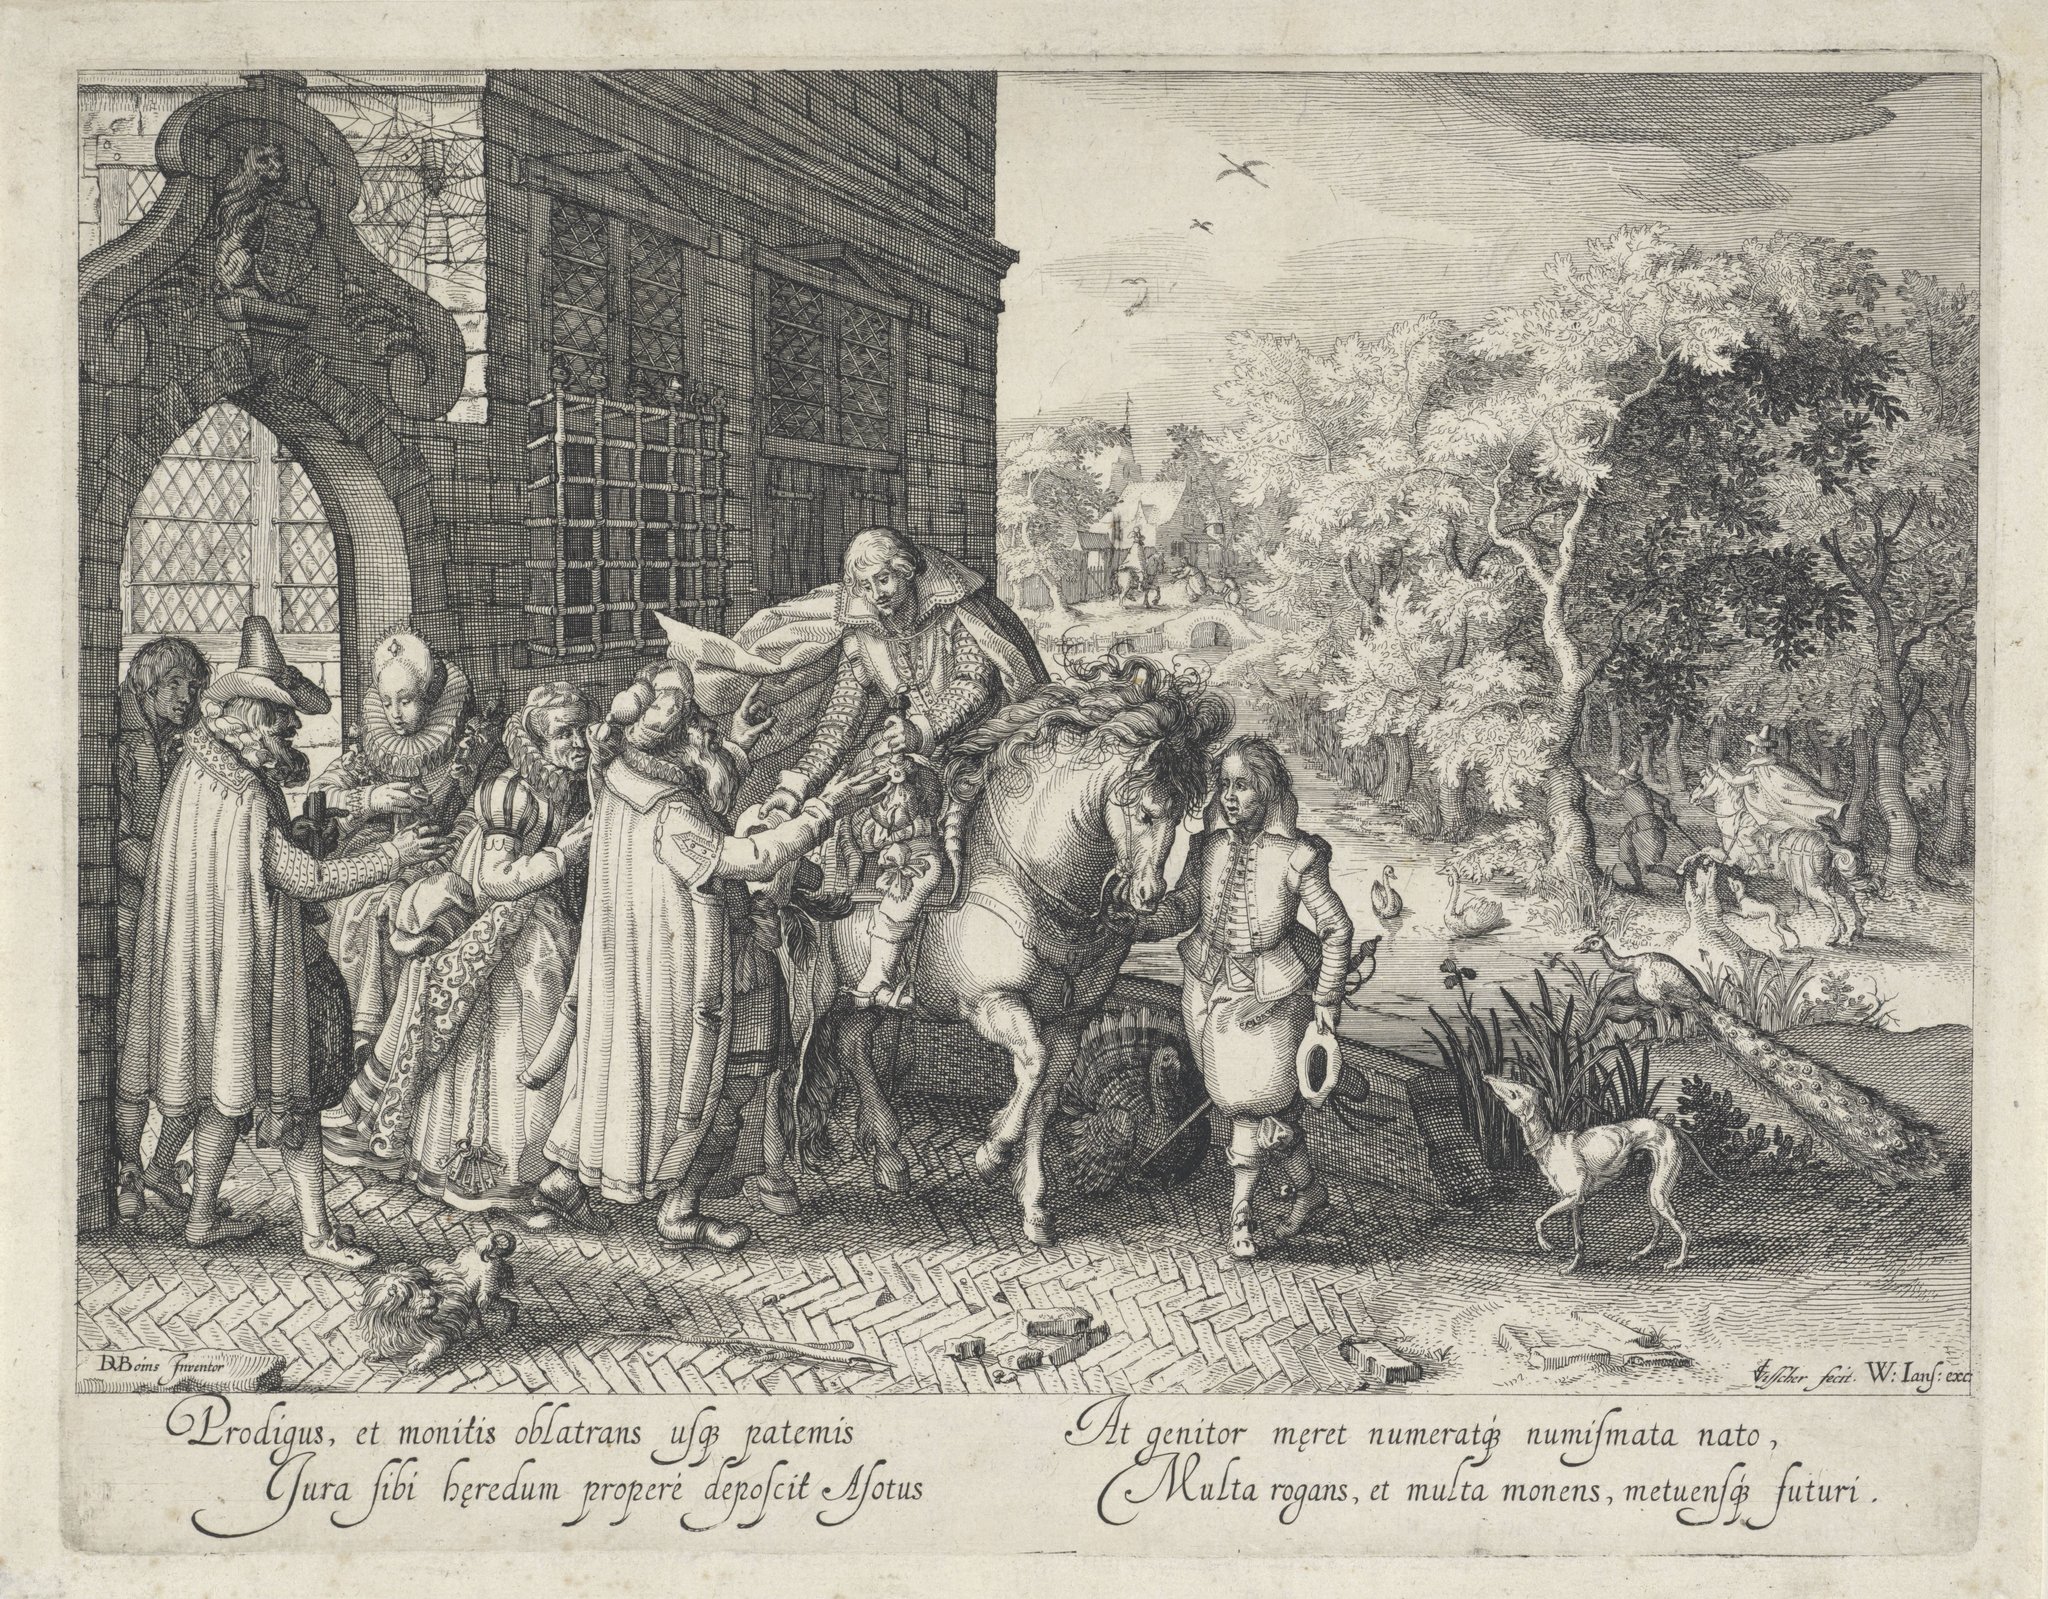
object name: print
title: De verloren zoon neemt afscheid van zijn vader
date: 1608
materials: paper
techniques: etching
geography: amsterdam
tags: clothes, costume (+ men's clothes), leave-taking and departure of the prodigal son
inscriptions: signature and address:, caption: ‘Prodigus, et monitis...metuensque futuri’ Lugt Lukas 15:11-32, collector's mark: 2228, signature: ‘DvBoins Inventor’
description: Voor de poort van een huis ontvangt de verloren zoon zijn erfdeel van zijn vader. Hij neemt afscheid van zijn familie terwijl hij op zijn paard zit. Het paard wordt vastgehouden door een jonge knecht. Rechtsachter rijdt de verloren zoon door een bos. De prent maakt deel uit van een vierdelige serie over de gelijkenis van de verloren zoon.